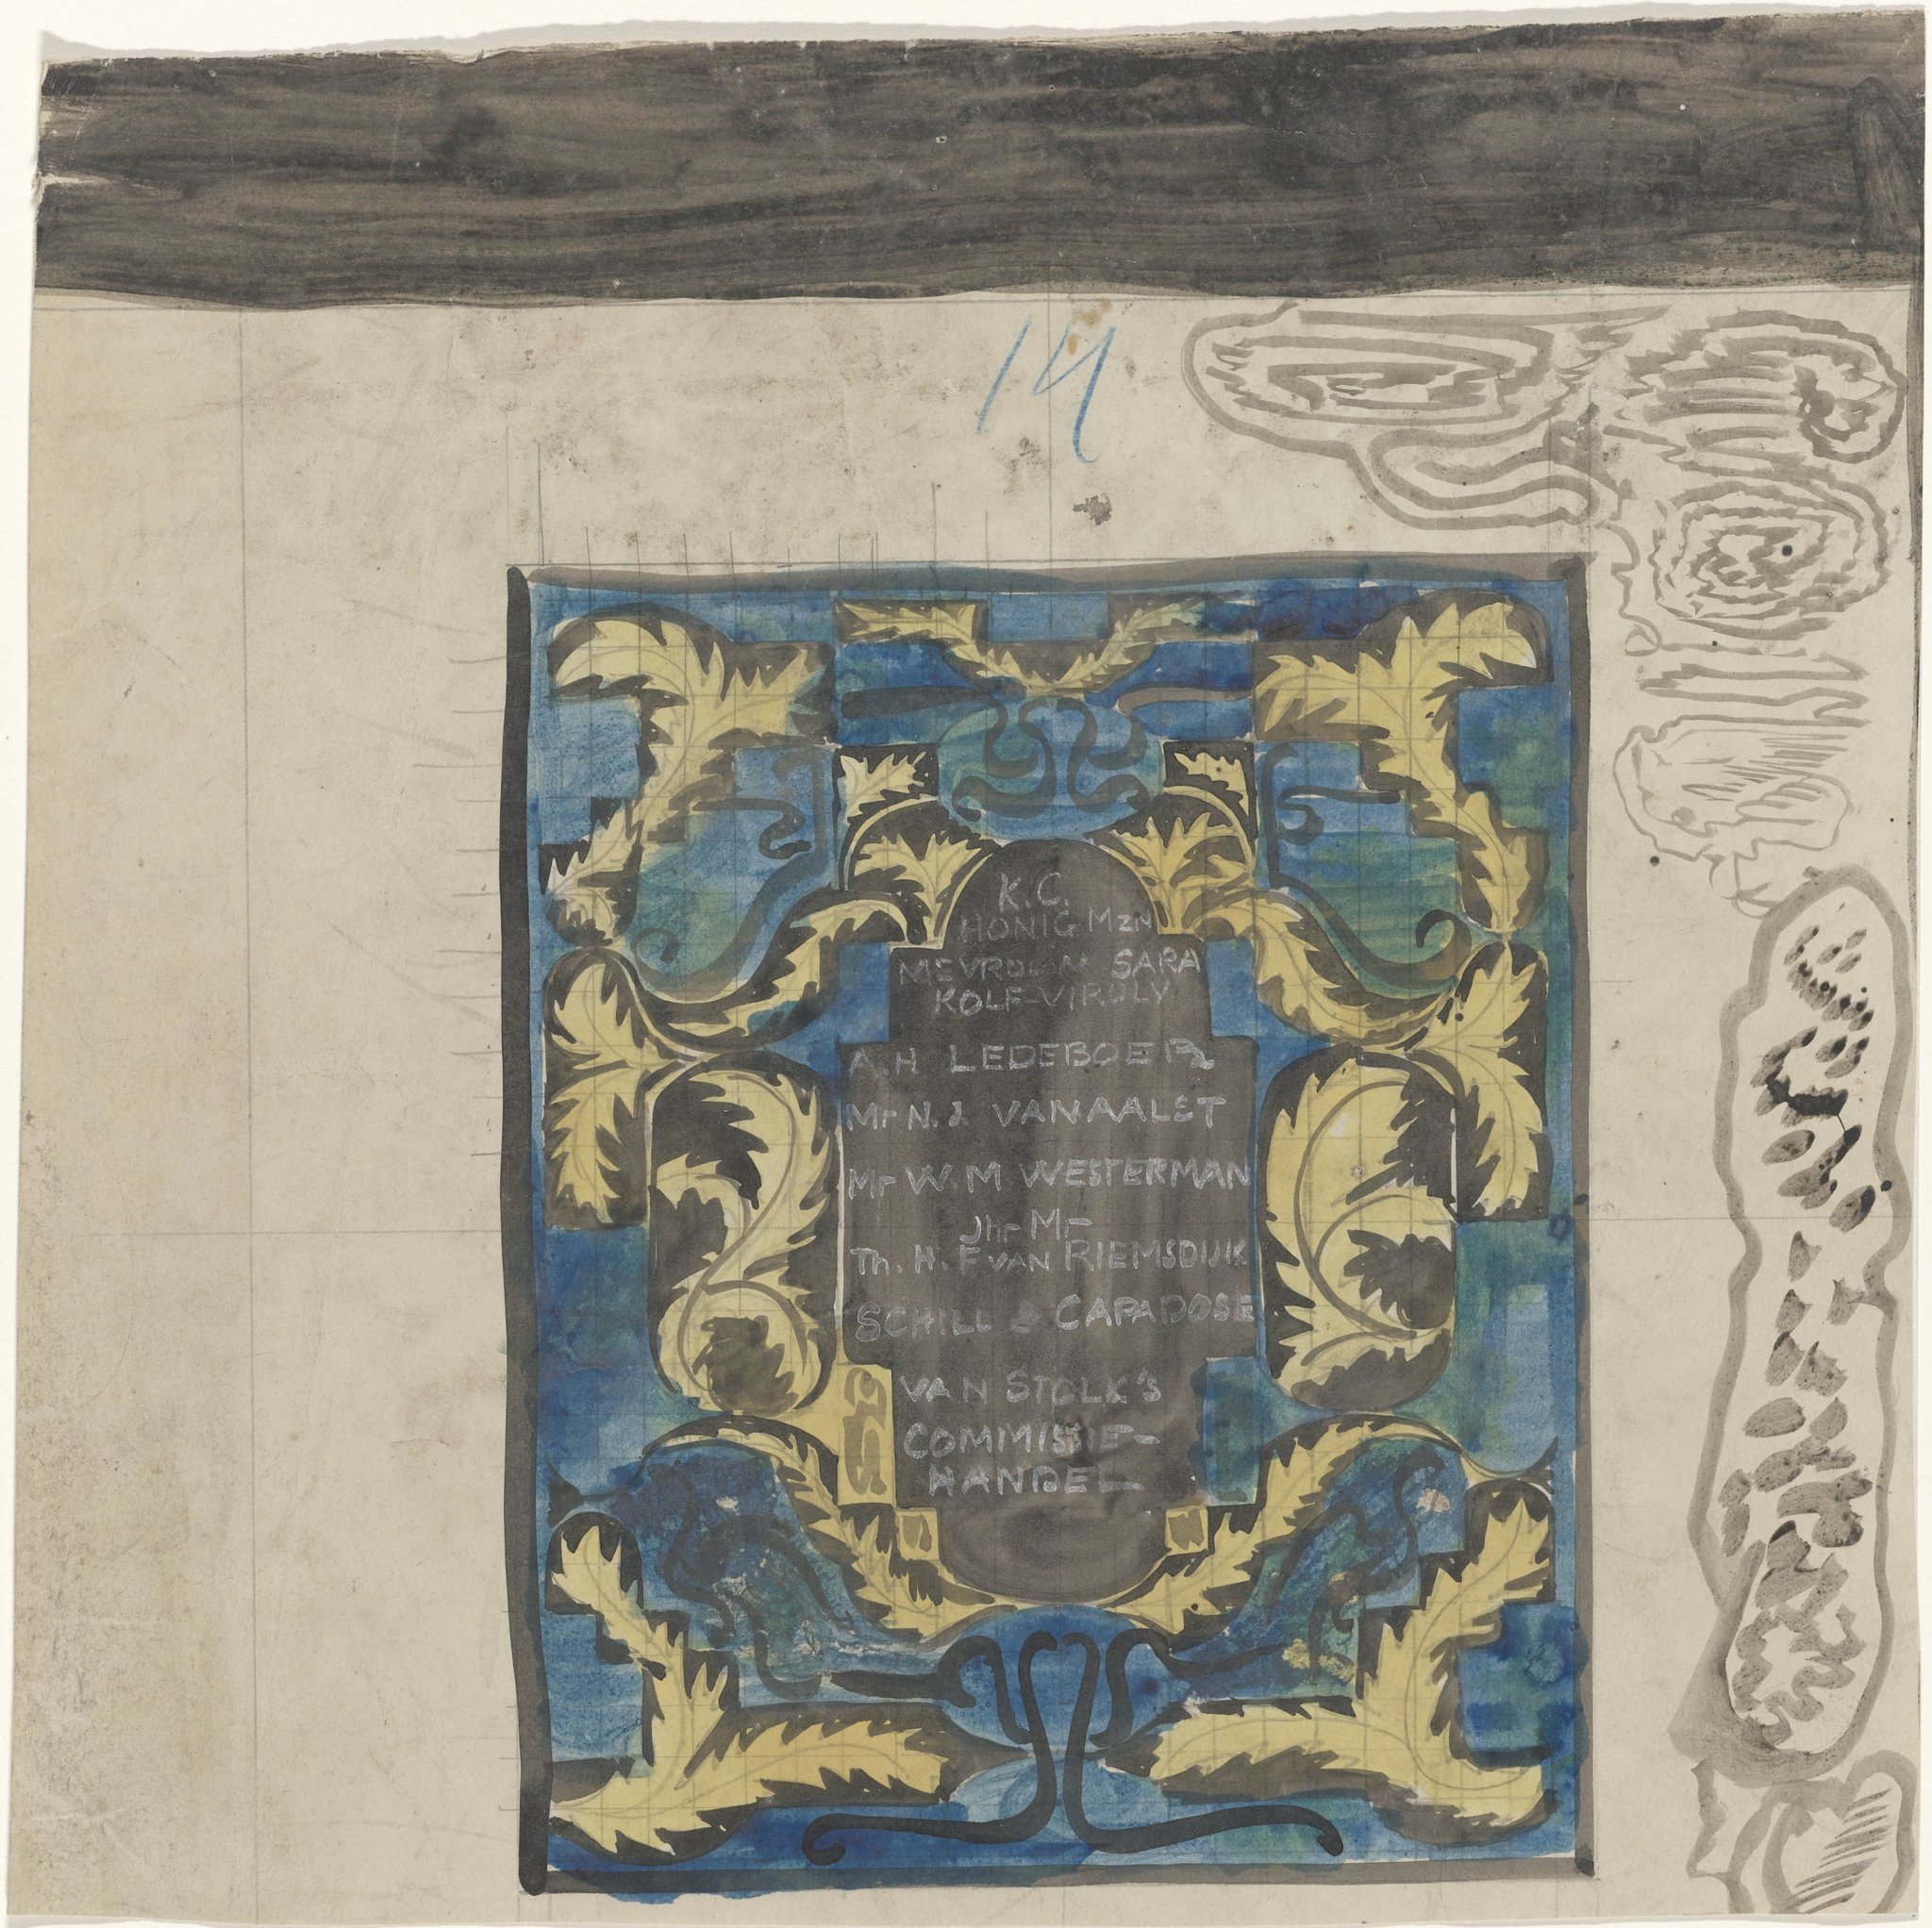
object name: design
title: Ornamentaal ontwerp met namen van Van Stolk's Commissiehandel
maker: carel adolph lion cachet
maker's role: draughtsman, print maker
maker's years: 1864-1945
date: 1874-1945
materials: paper, pencil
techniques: brush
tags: advertising, names of organizations, companies, trade unions, etc.